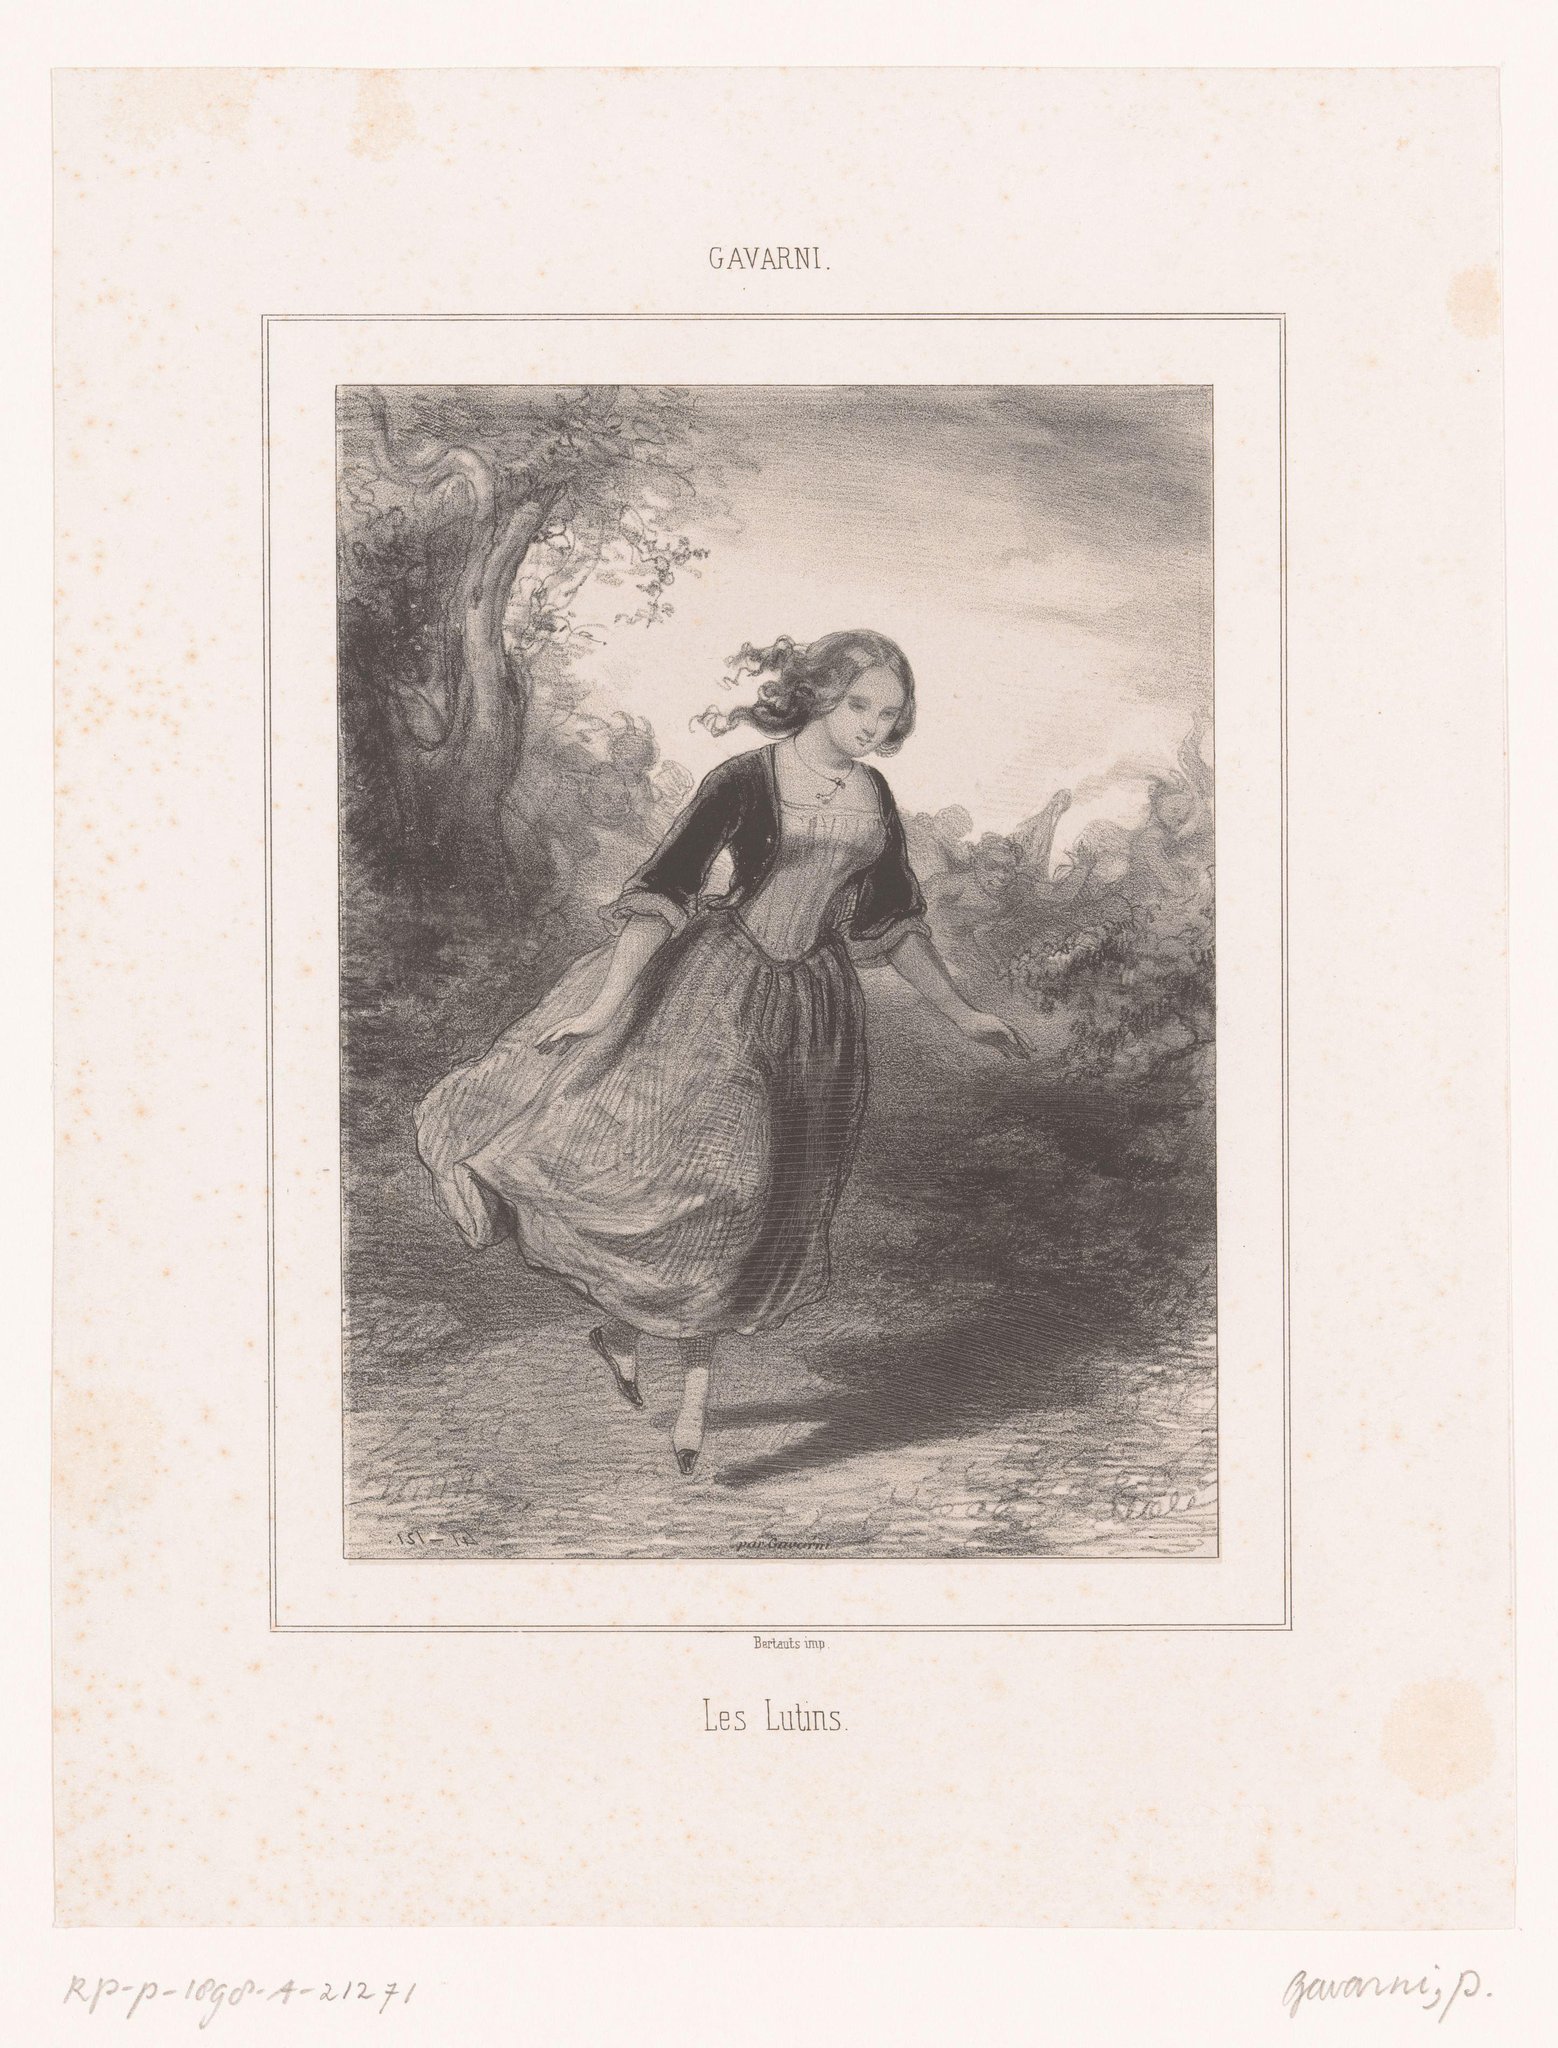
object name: print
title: Meisje achtervolgd door boswezens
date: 1843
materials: paper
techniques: lithograph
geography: paris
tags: adolescent, young woman, maiden, elf, goblins, hobgoblins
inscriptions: check stamp: Lugt 470b, collector's mark: Lugt 964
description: Prent gebruikt als illustratie voor de balade Les Farfadets, in het album met bladmuziek Les Lys et les roses, Parijs: Bertauts, 1841. Prent ook gebruikt voor: Curmer, L. Les Beaux-Arts. Illustration des Arts et de la Littérature. Parijs: L. Curmer, 1843. Vol. 1, 3e livraison. Prent eveneens gebruikt voor: Curmer, L. La Giralda. Parijs: L. Curmer, 1845.